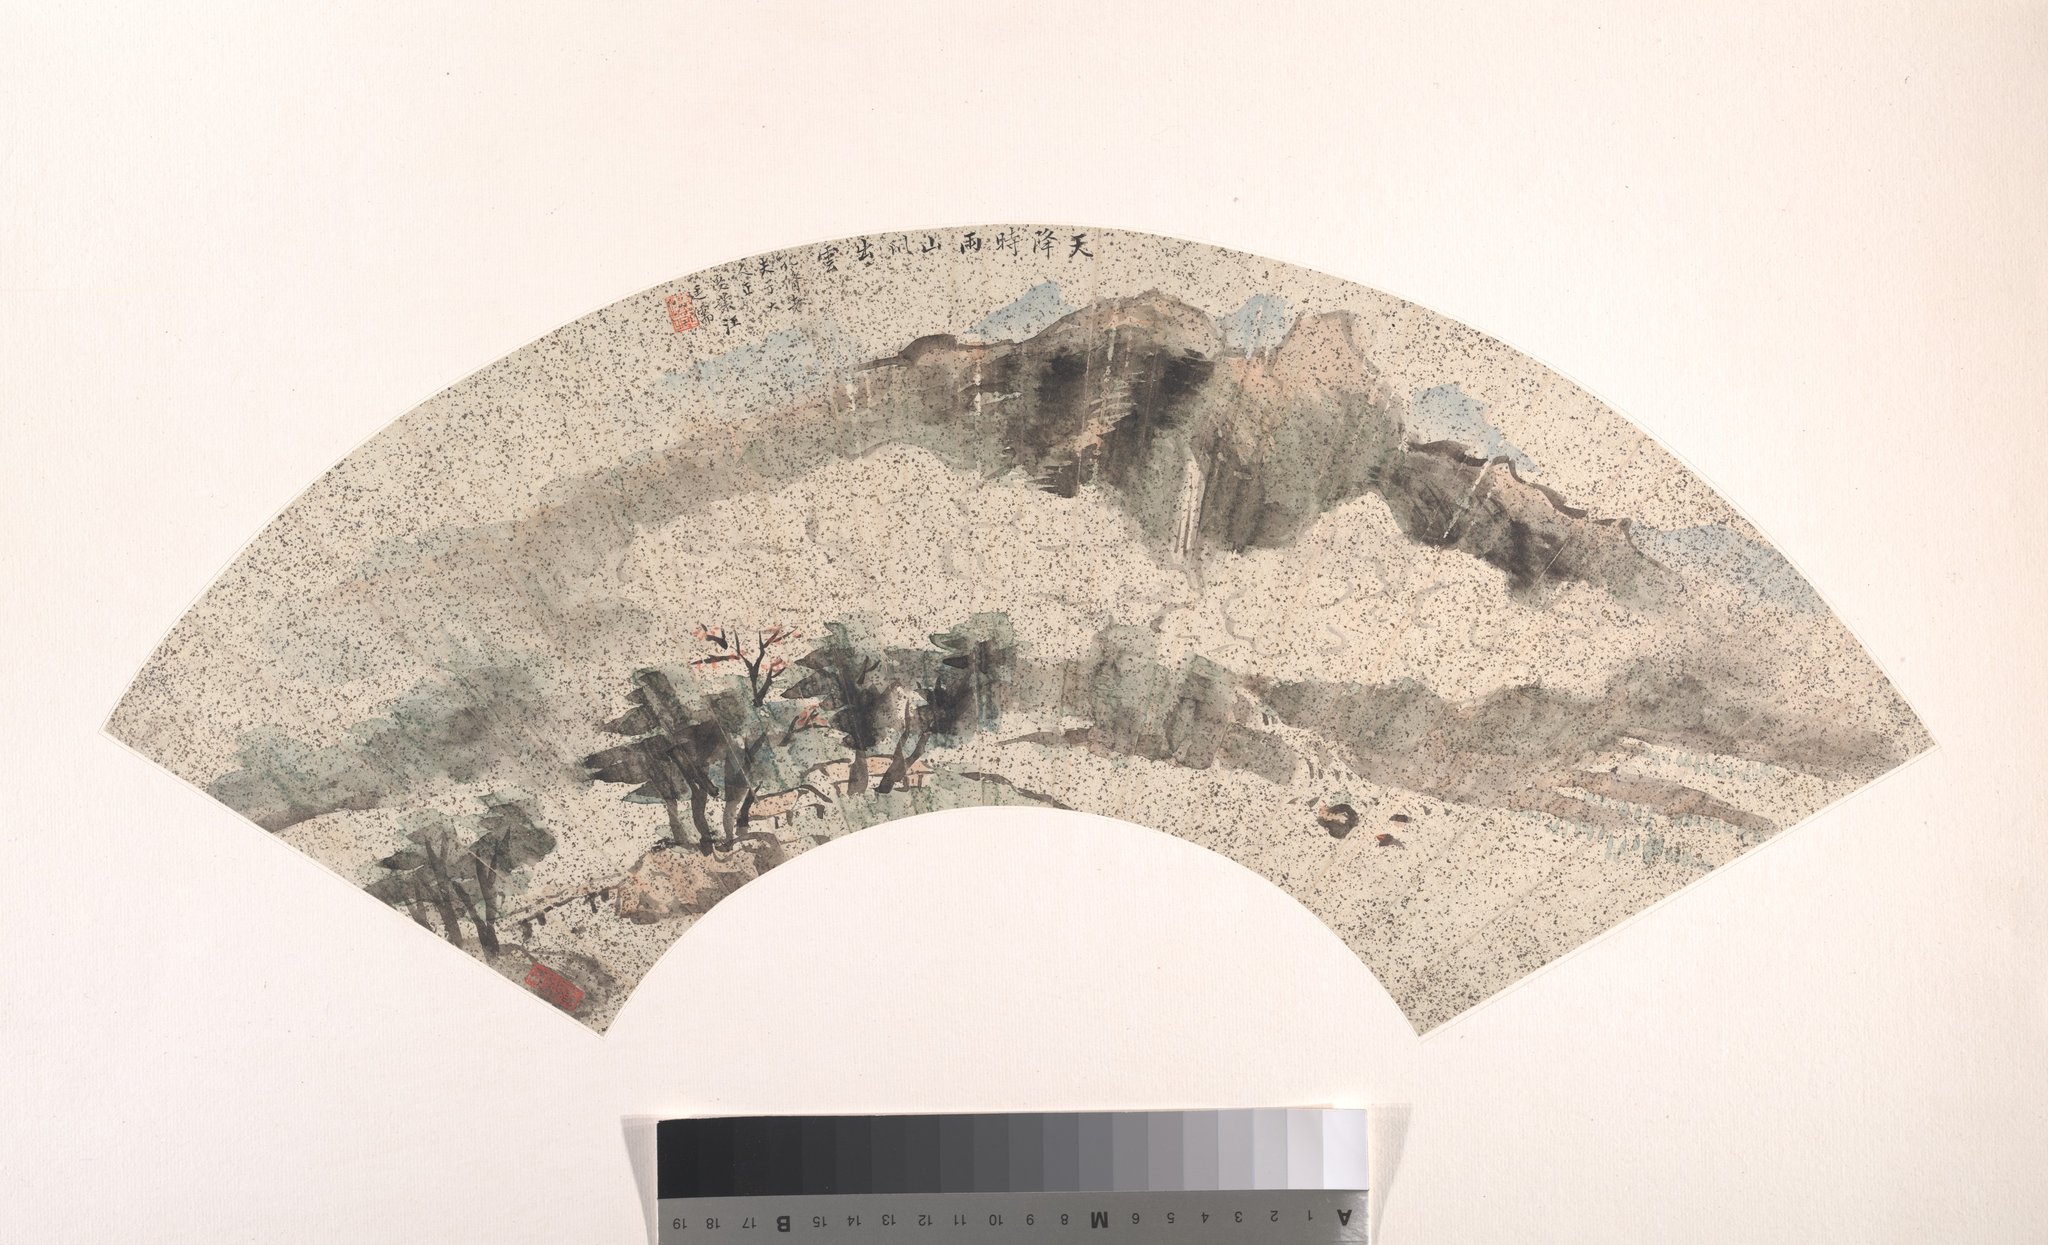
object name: folding fan mounted a an album leaf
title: Landscape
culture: chinese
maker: wang tingru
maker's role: artist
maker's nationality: chinese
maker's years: 1804-1852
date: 1801-1900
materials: gold, ink, paper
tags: mountains,landscapes